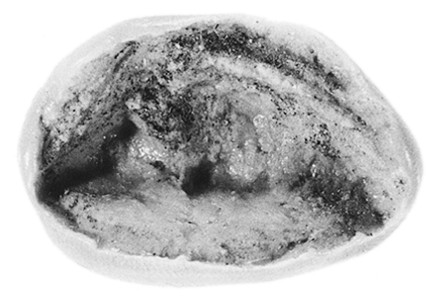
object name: sealing fragment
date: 2030-1640 BCE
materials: clay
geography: egypt